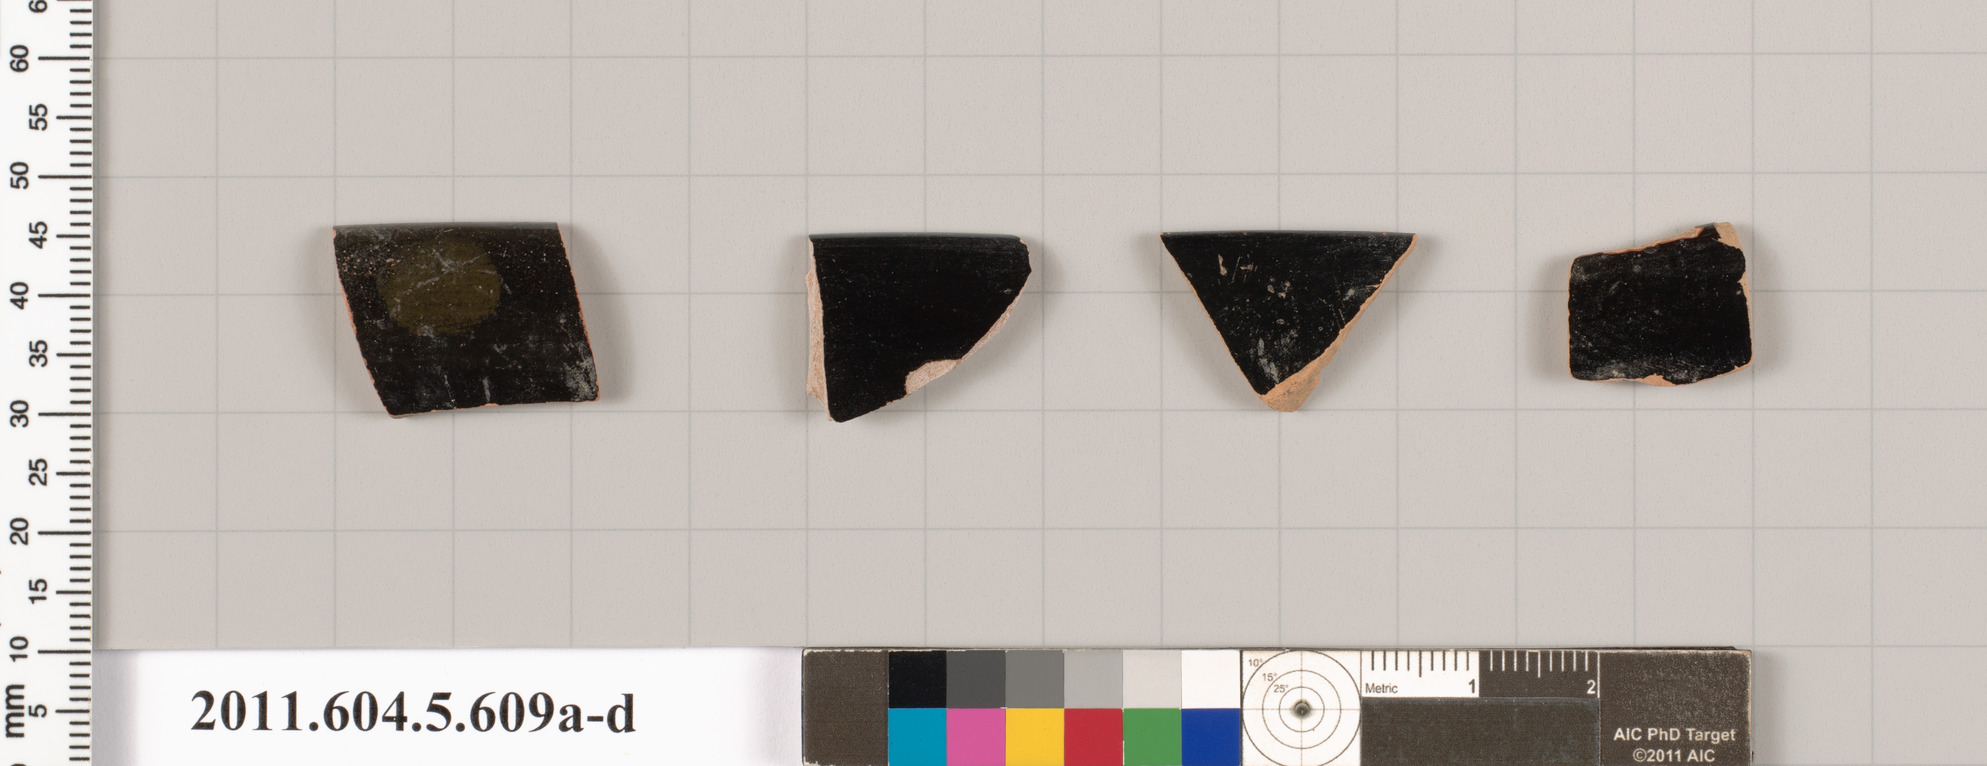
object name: kylix fragment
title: Terracotta rim fragments of kylikes (drinking cups)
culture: greek, attic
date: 600-401 BCE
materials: terracotta